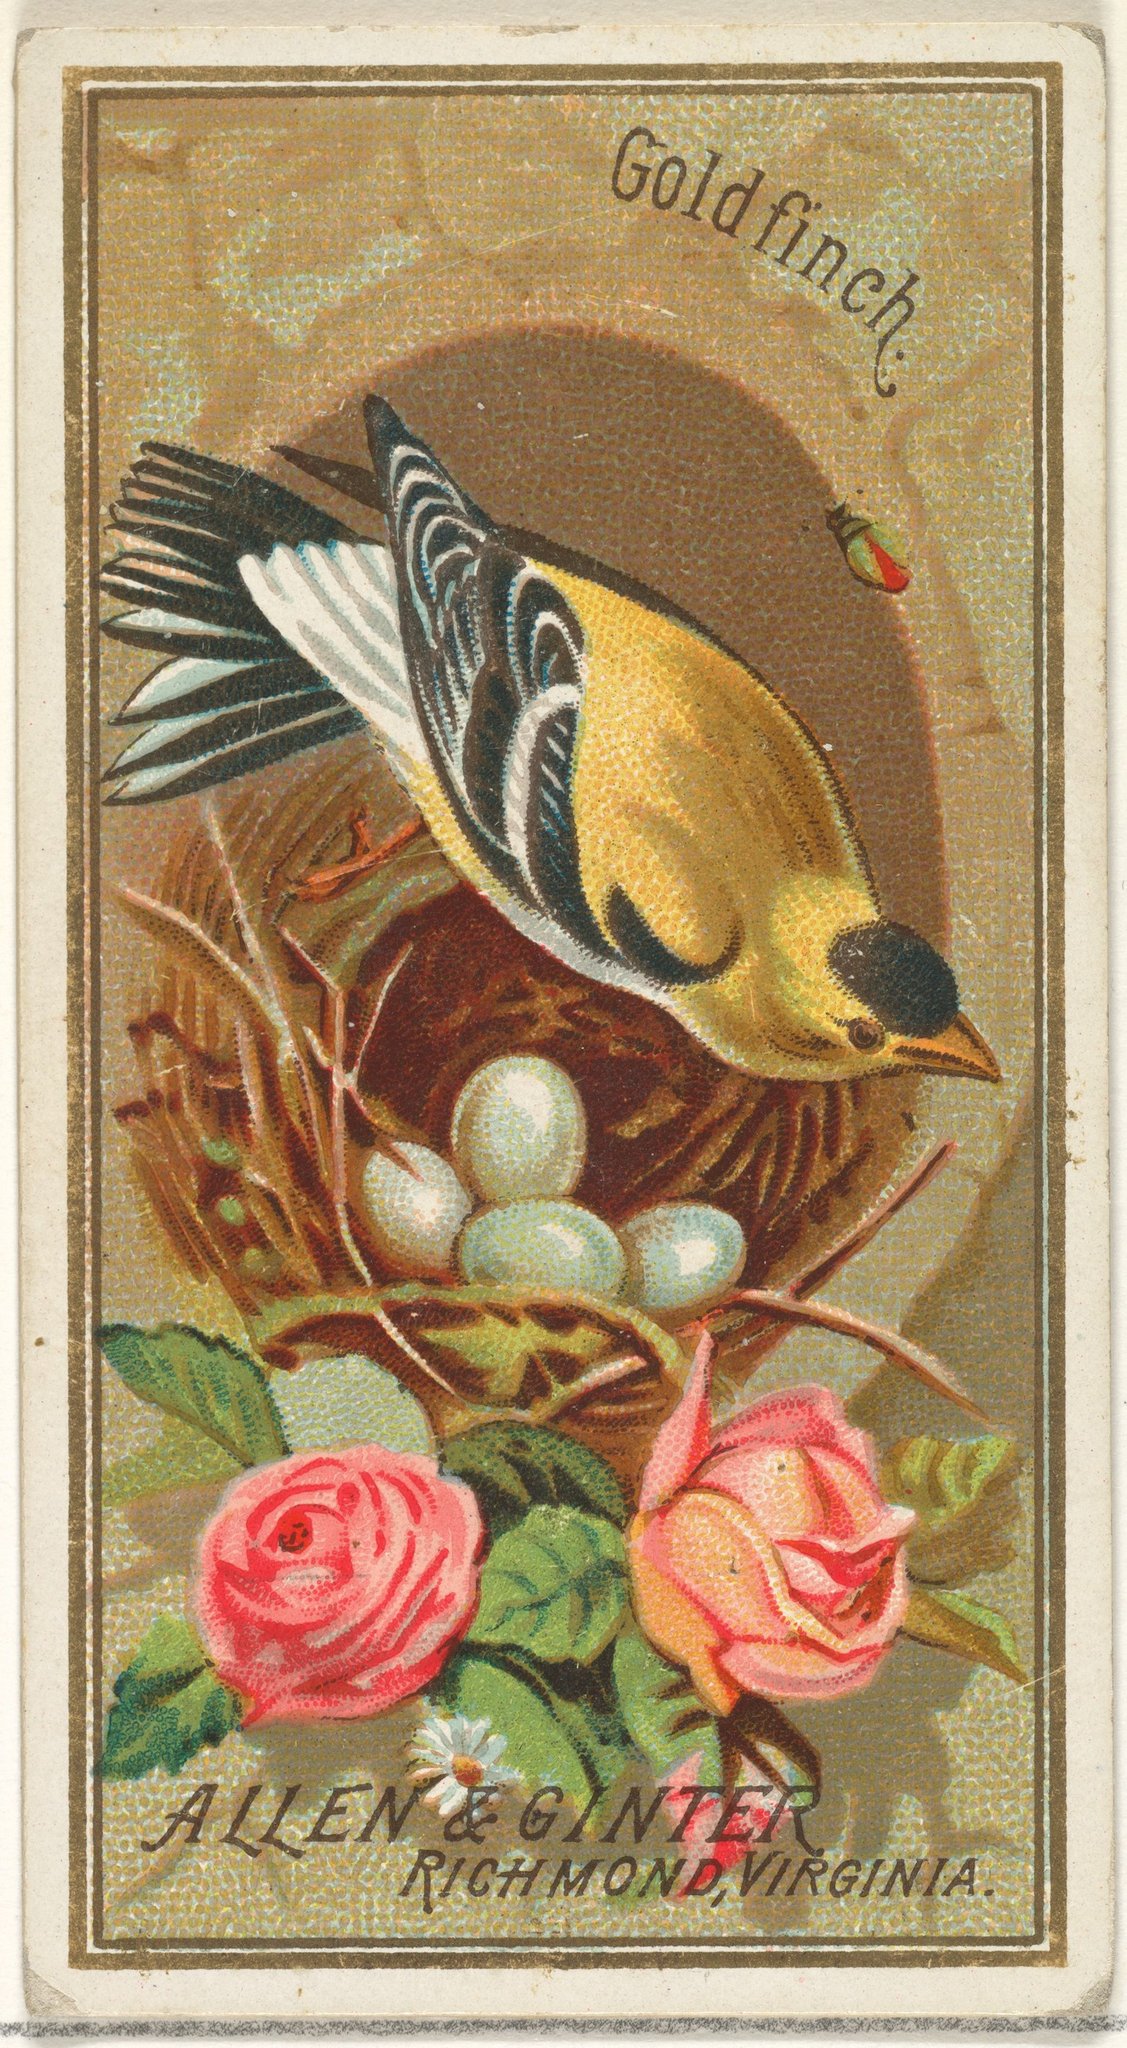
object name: print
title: Goldfinch, from the Birds of America series (N4) for Allen & Ginter Cigarettes Brands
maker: allen & ginter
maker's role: publisher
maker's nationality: american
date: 1888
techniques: color lithograph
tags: birds,roses,eggs